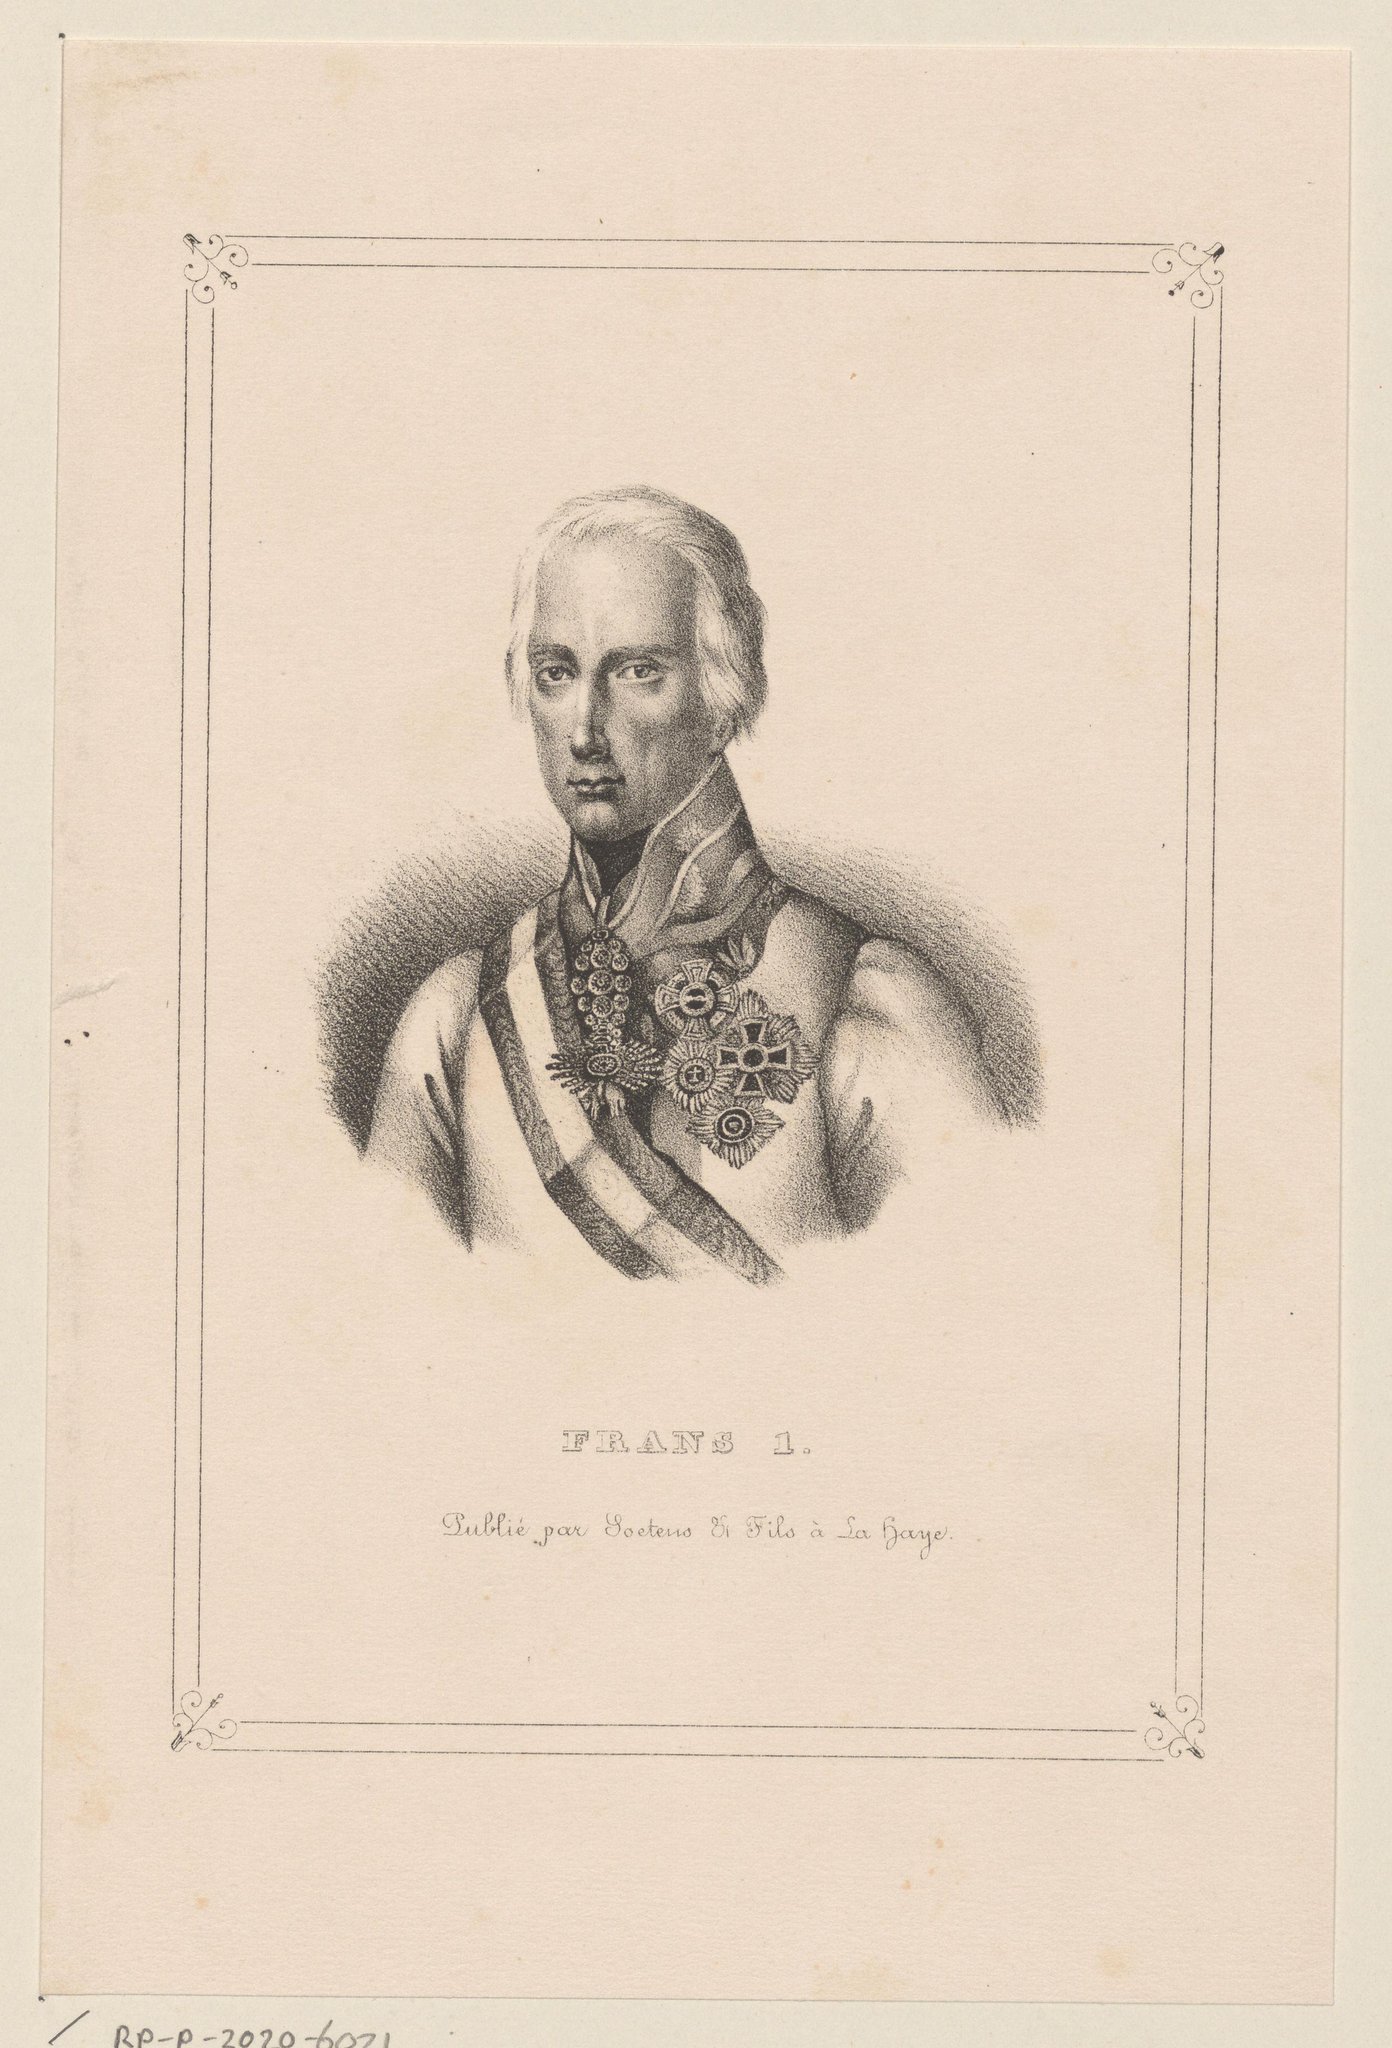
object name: print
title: Serie portretten door Soetens & Fils omstreeks 1838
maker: Anonymous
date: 1837-1840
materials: paper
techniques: lithograph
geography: the hague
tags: frans ii (rooms-duits keizer), historical persons, emperor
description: Deze prent maakte vermoedelijk deel uit van een serie uitgegeven door Soetens & Fils omstreeks 1838, opgedragen aan de Prins van Oranje. In de 'Prospectus en Inteekenlijst' stond vermeld dat het zal bestaan uit een onbepaald aantal portretten, waarvan er drie of vier per maand verschijnen. Zie Van Someren.